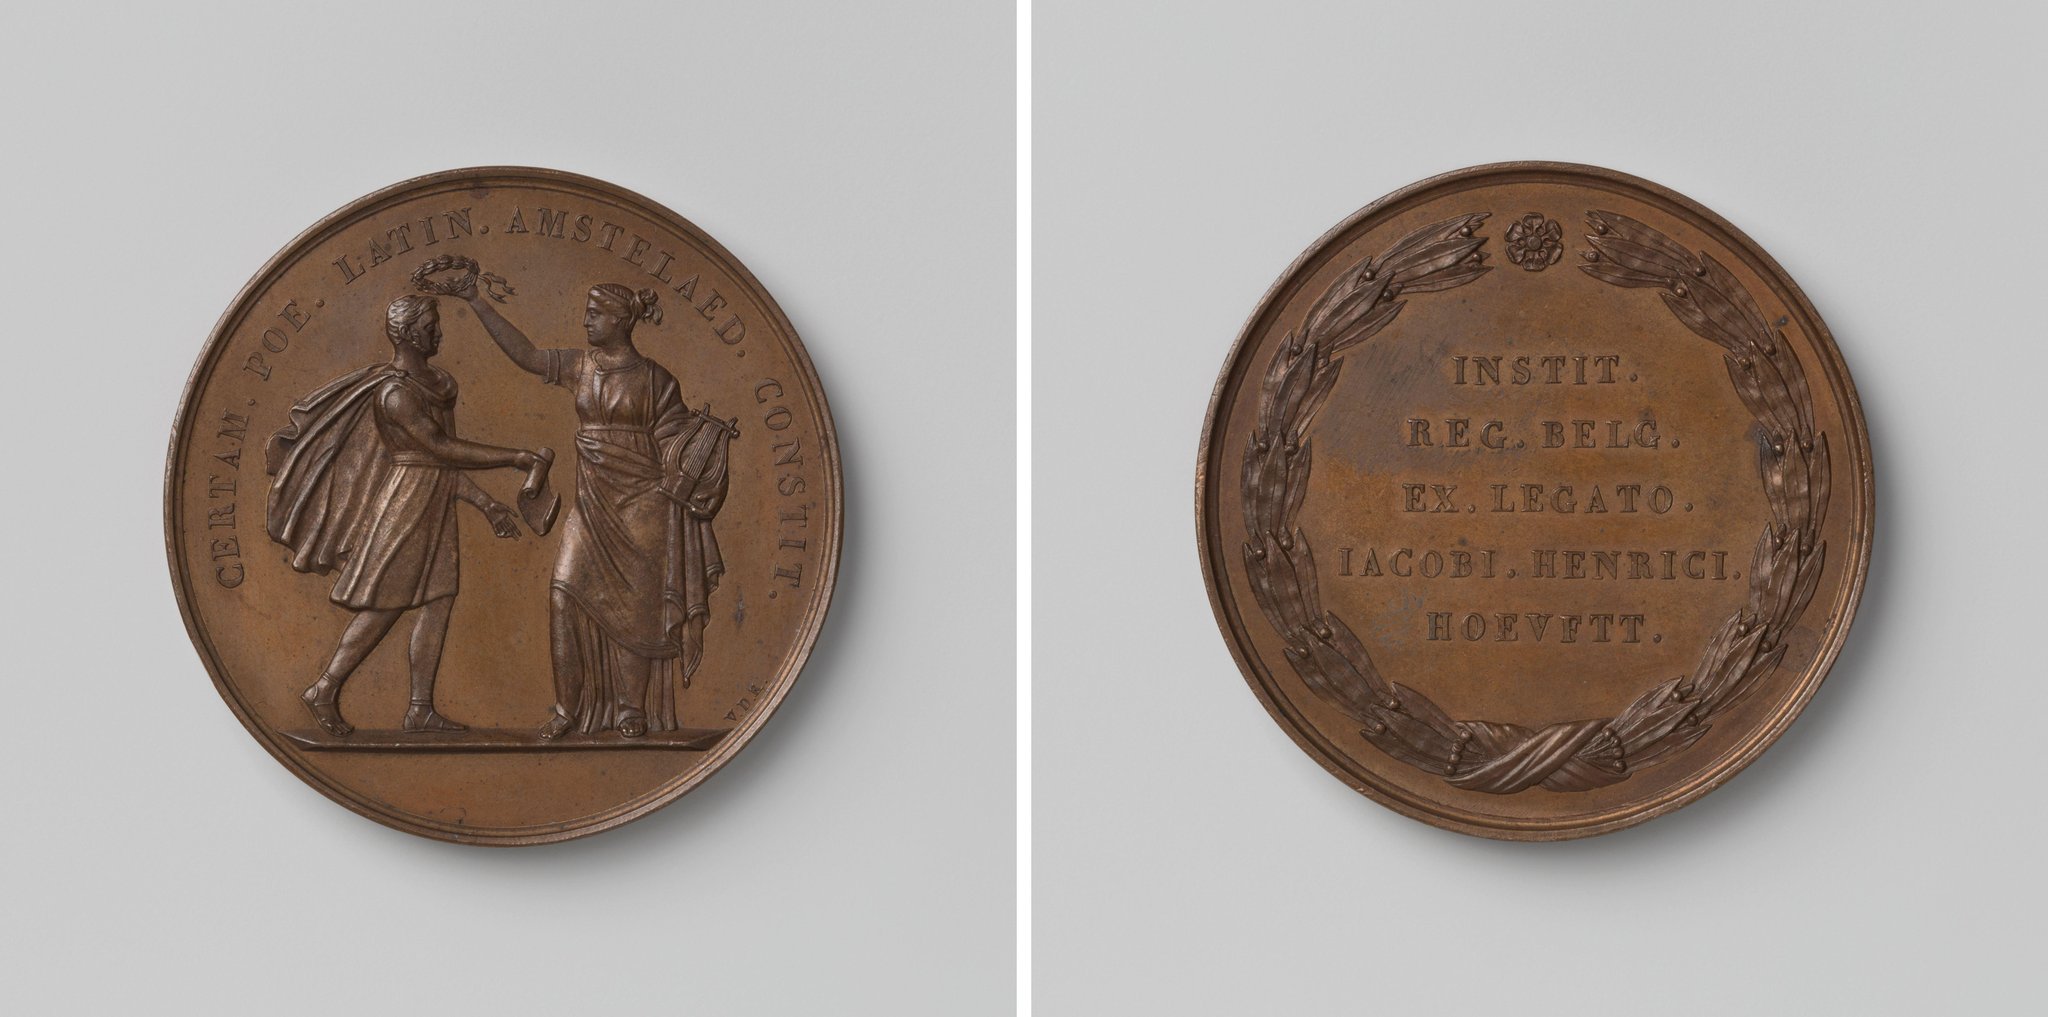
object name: medal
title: Legaat van J.H. Hoeufft ter bevordering van de beoefening der Latijnse poezie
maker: david van der kellen (1804-1879)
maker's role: die cutter, draughtsman, print maker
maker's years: 1804-1879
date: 1843-1844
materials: bronze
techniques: striking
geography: utrecht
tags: dordrecht, jacob hendrik hoeufft (1756-1843), amsterdam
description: Bronzen penning. Voorzijde: vrouw in antieke kledij, voorstellende Muze, houdt lier in linkerhand en kroont met lauwerkrans in uitgestrekte, geheven rechterhand een op haar toelopende man, die rol papier aanbiedt binnen omschrift. Keerzijde: opschrift binnen krans van olijftakken